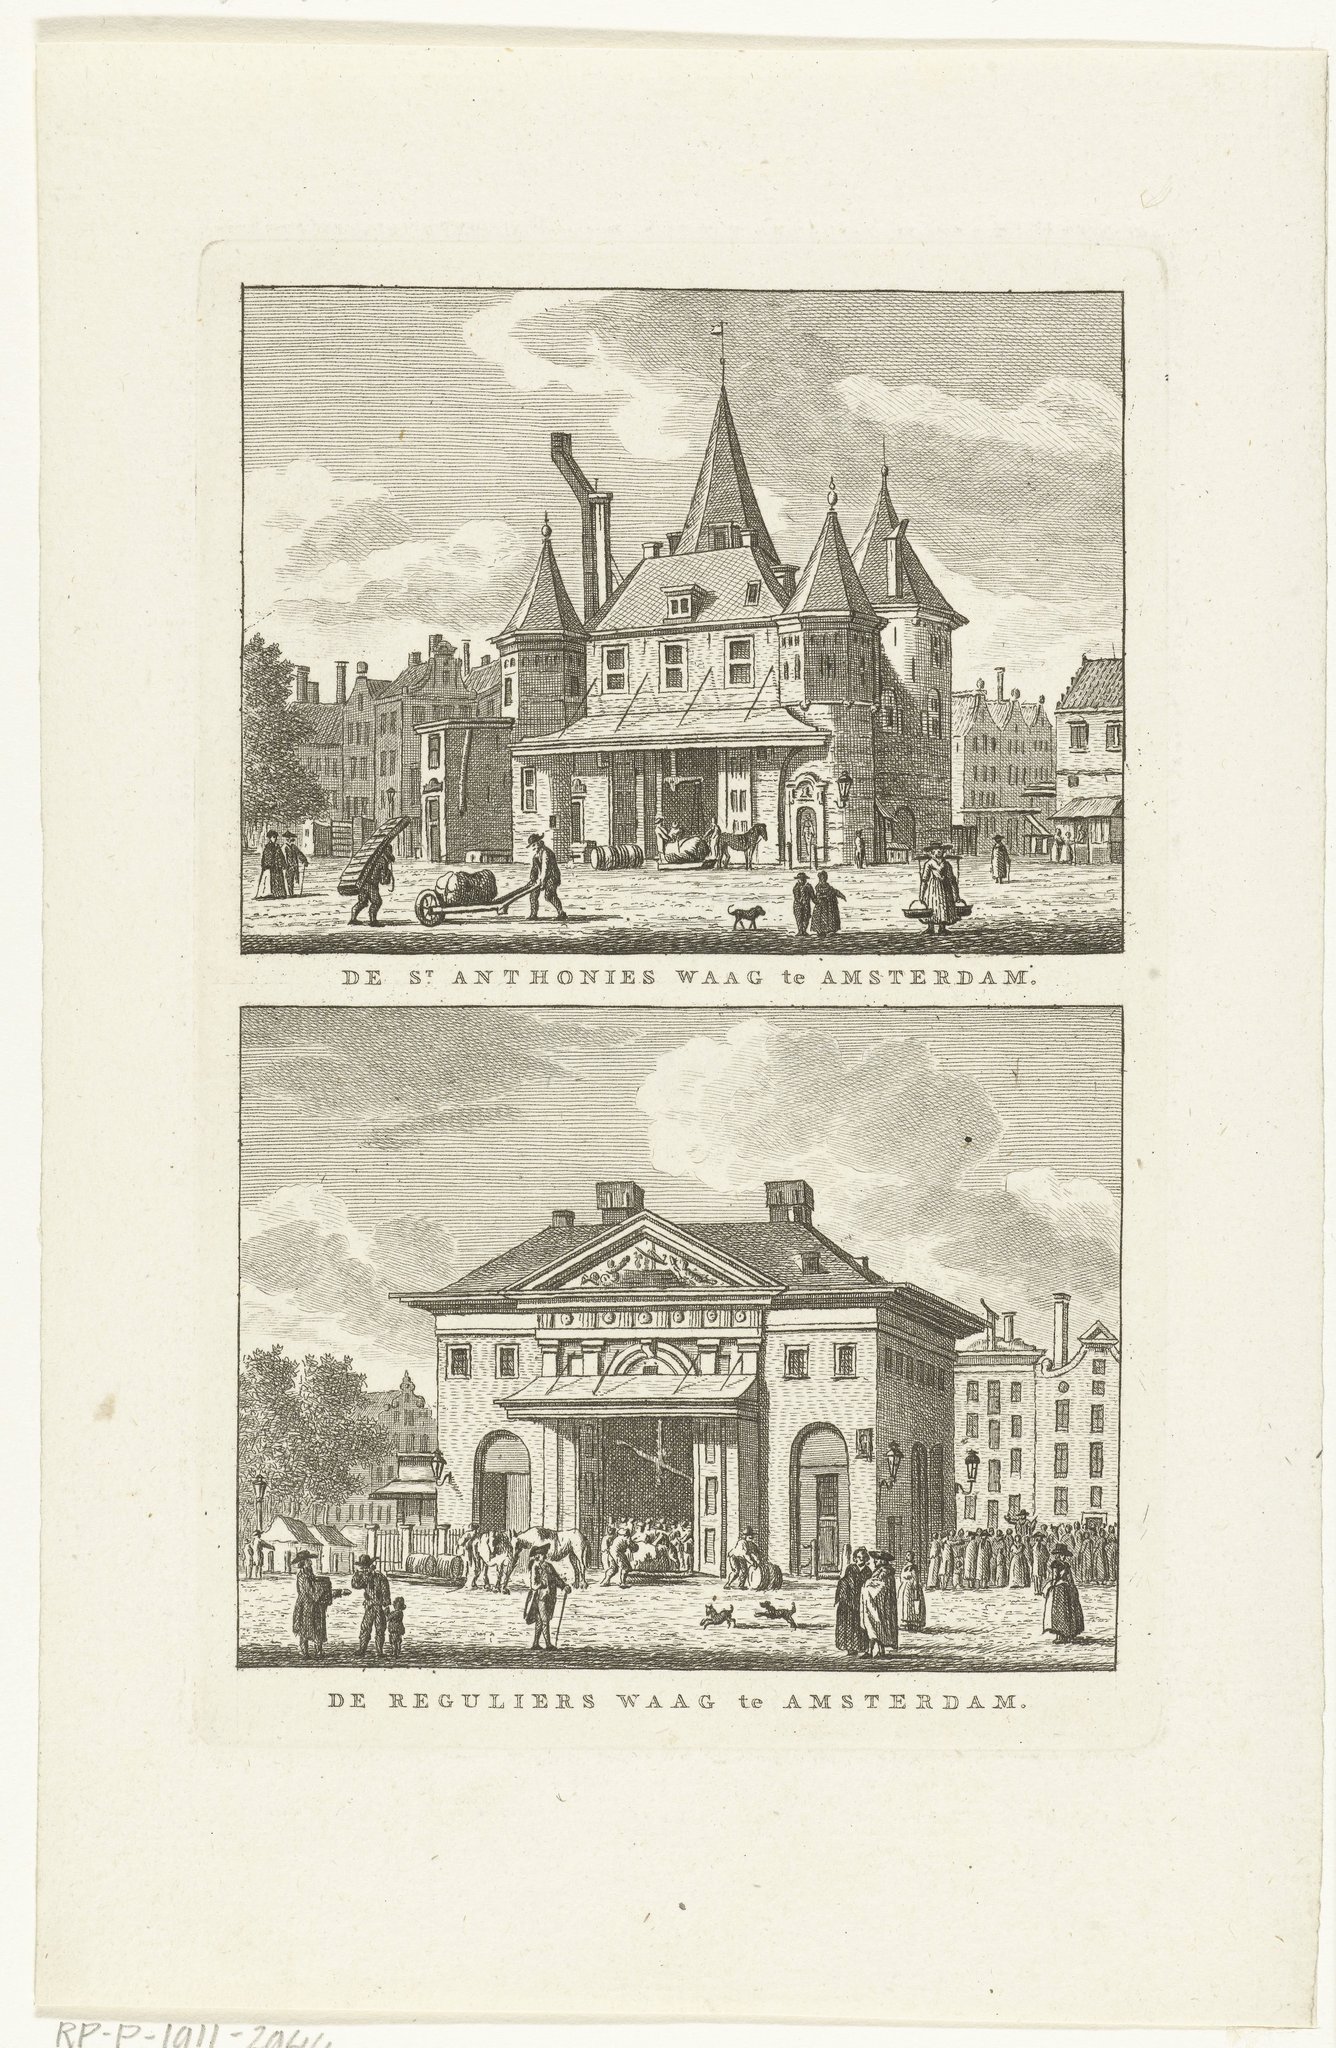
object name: print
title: Twee stadsgezichten te Amsterdam: Waag op Nieuwmarkt en Regulierswaag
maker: carel frederik bendorp (i)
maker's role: print maker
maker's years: 1736-1814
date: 1786-1792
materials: paper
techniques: etching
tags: weigh-house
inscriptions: collector's mark: Lugt 2228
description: Prent uit: Vaderlandsche gezichten, of afbeeldingen van den tegenwoordigen staat der Vereenigde Nederlanden (…). Amsterdam: Hendrik Gartman, Willem Vermandel en Jan Willem Smit, 1786-1792. Uitgegeven in afleveringen met ieder een eigen bifolium en inhoudsopgave. Alle prenten in deze publicatie zijn gegraveerd door Carel Frederik Bendorp (I) en, in de meeste gevallen, gebaseerd op tekeningen van Jan Bulthuis.